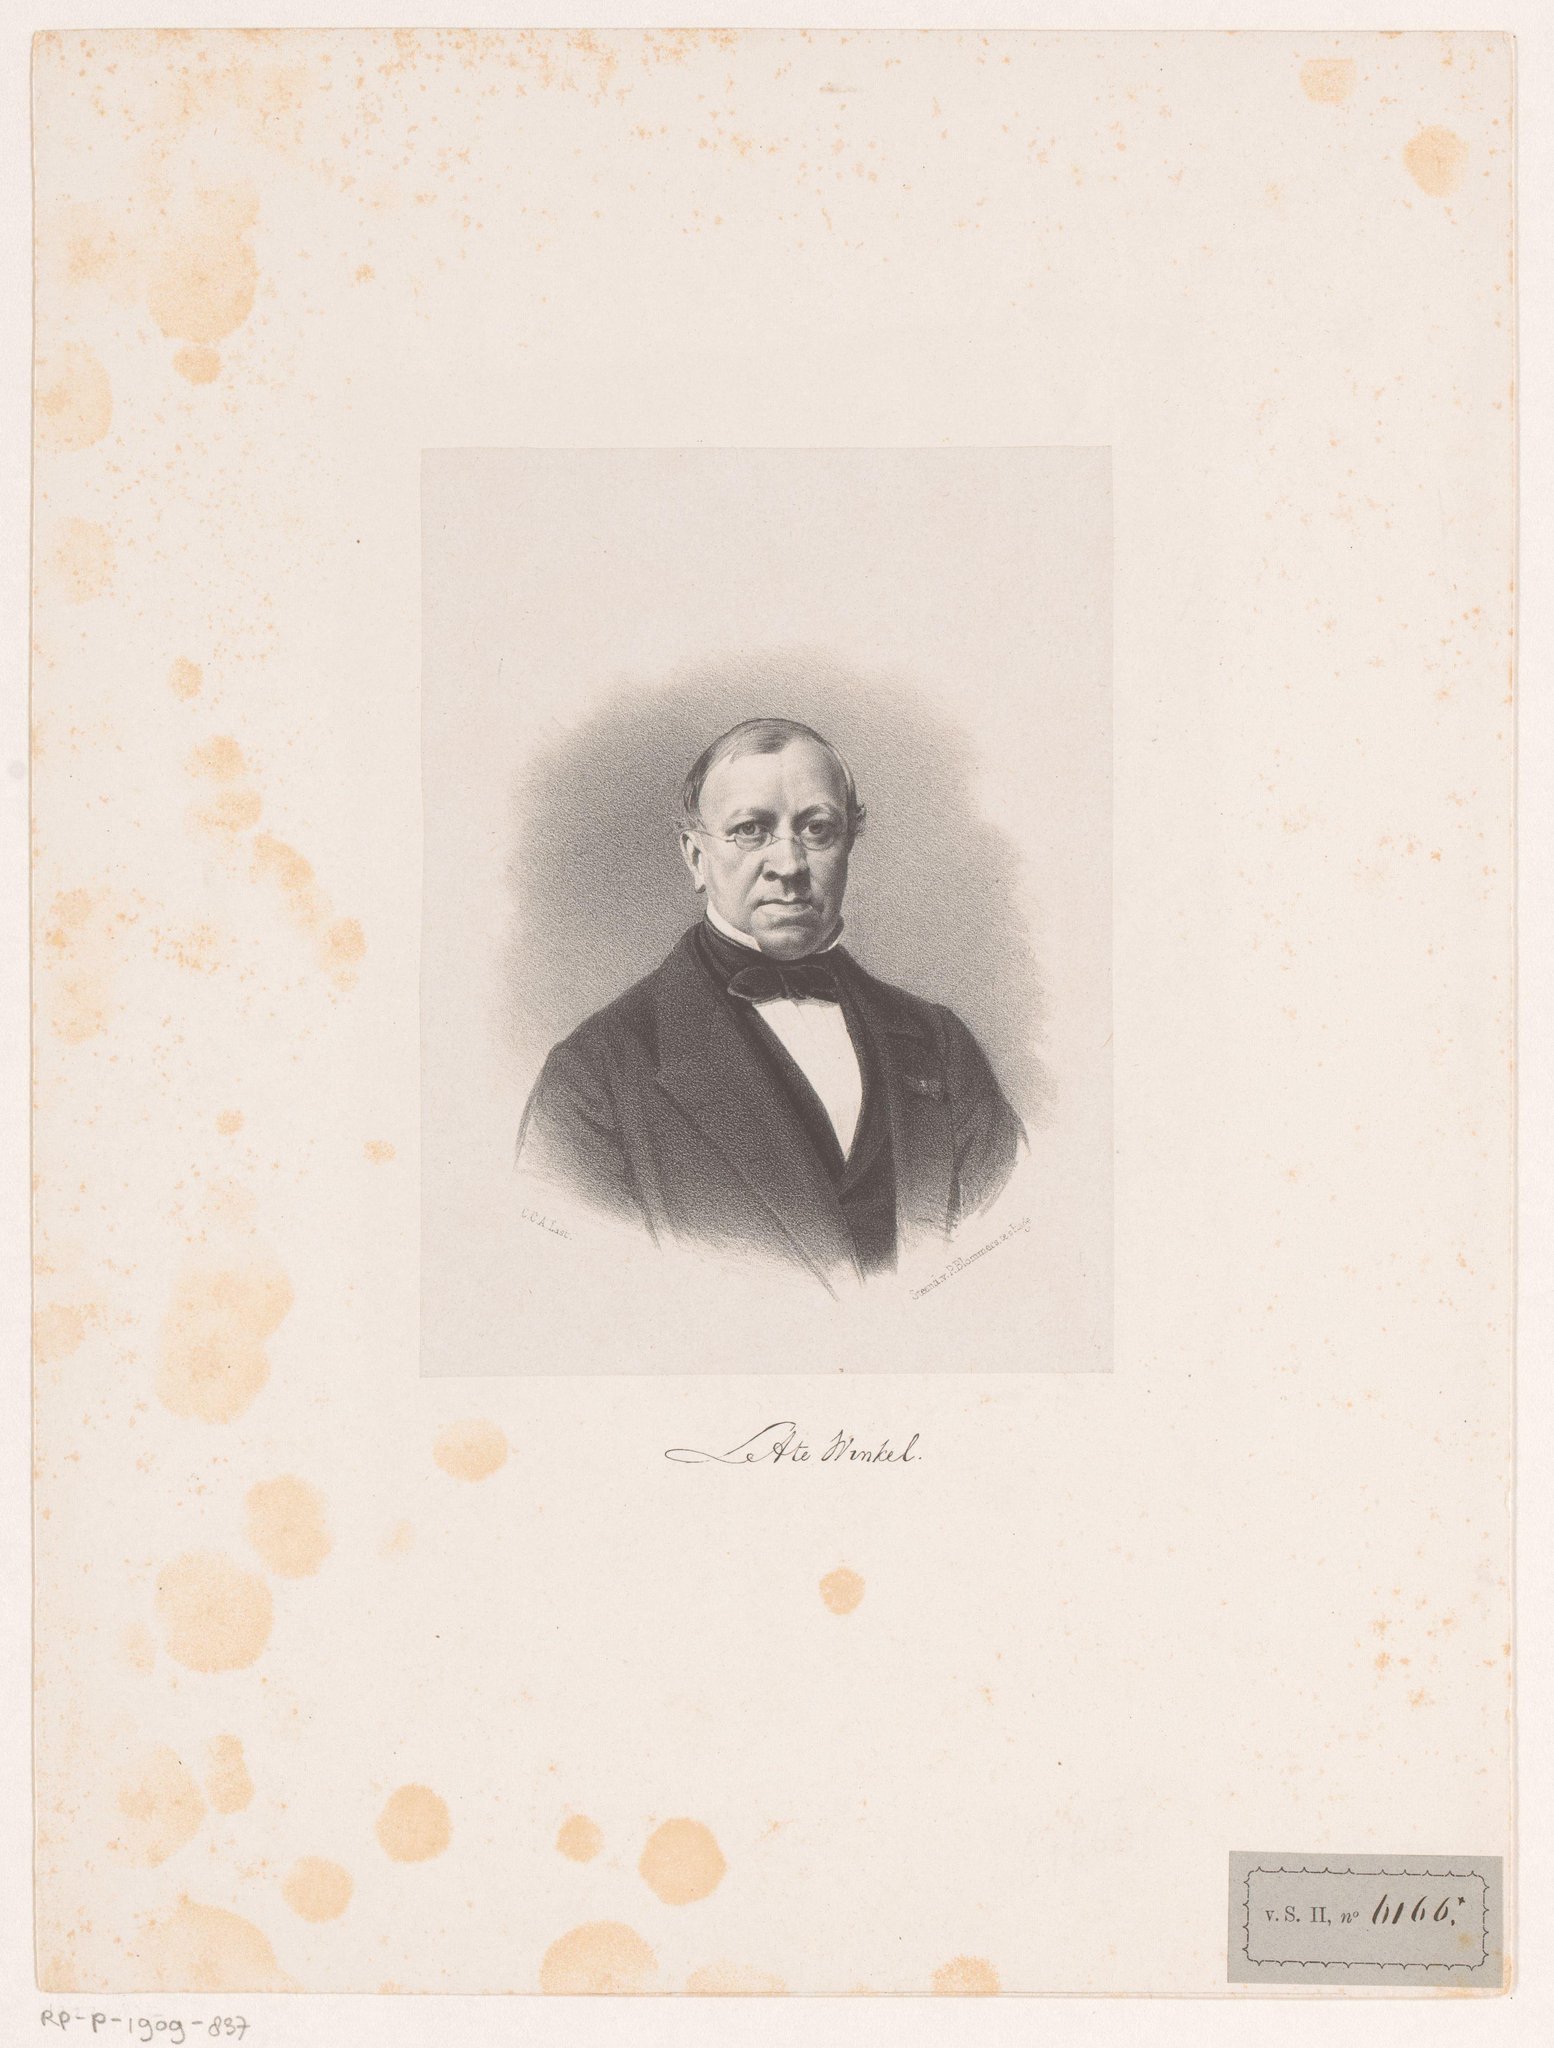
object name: print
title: Portret van Lambert Allard te Winkel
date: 1842-1887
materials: paper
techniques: lithograph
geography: the hague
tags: arnhem, leiden, eyeglasses, spectacles, historical persons (+ (full) bust portrait)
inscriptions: collector's mark: Lugt 2228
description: De geportretteerde draagt een bril. Onder het portret zijn signatuur.